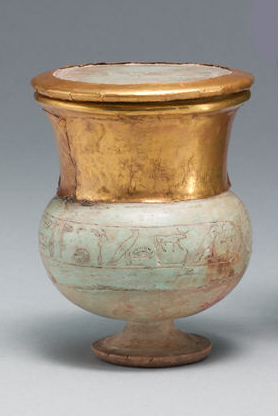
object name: jar, wide necked, inscribed for thutmose iii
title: Wide-necked jar and lid naming Thutmose III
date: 1479-1425 BCE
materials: gold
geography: egypt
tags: hieroglyphs